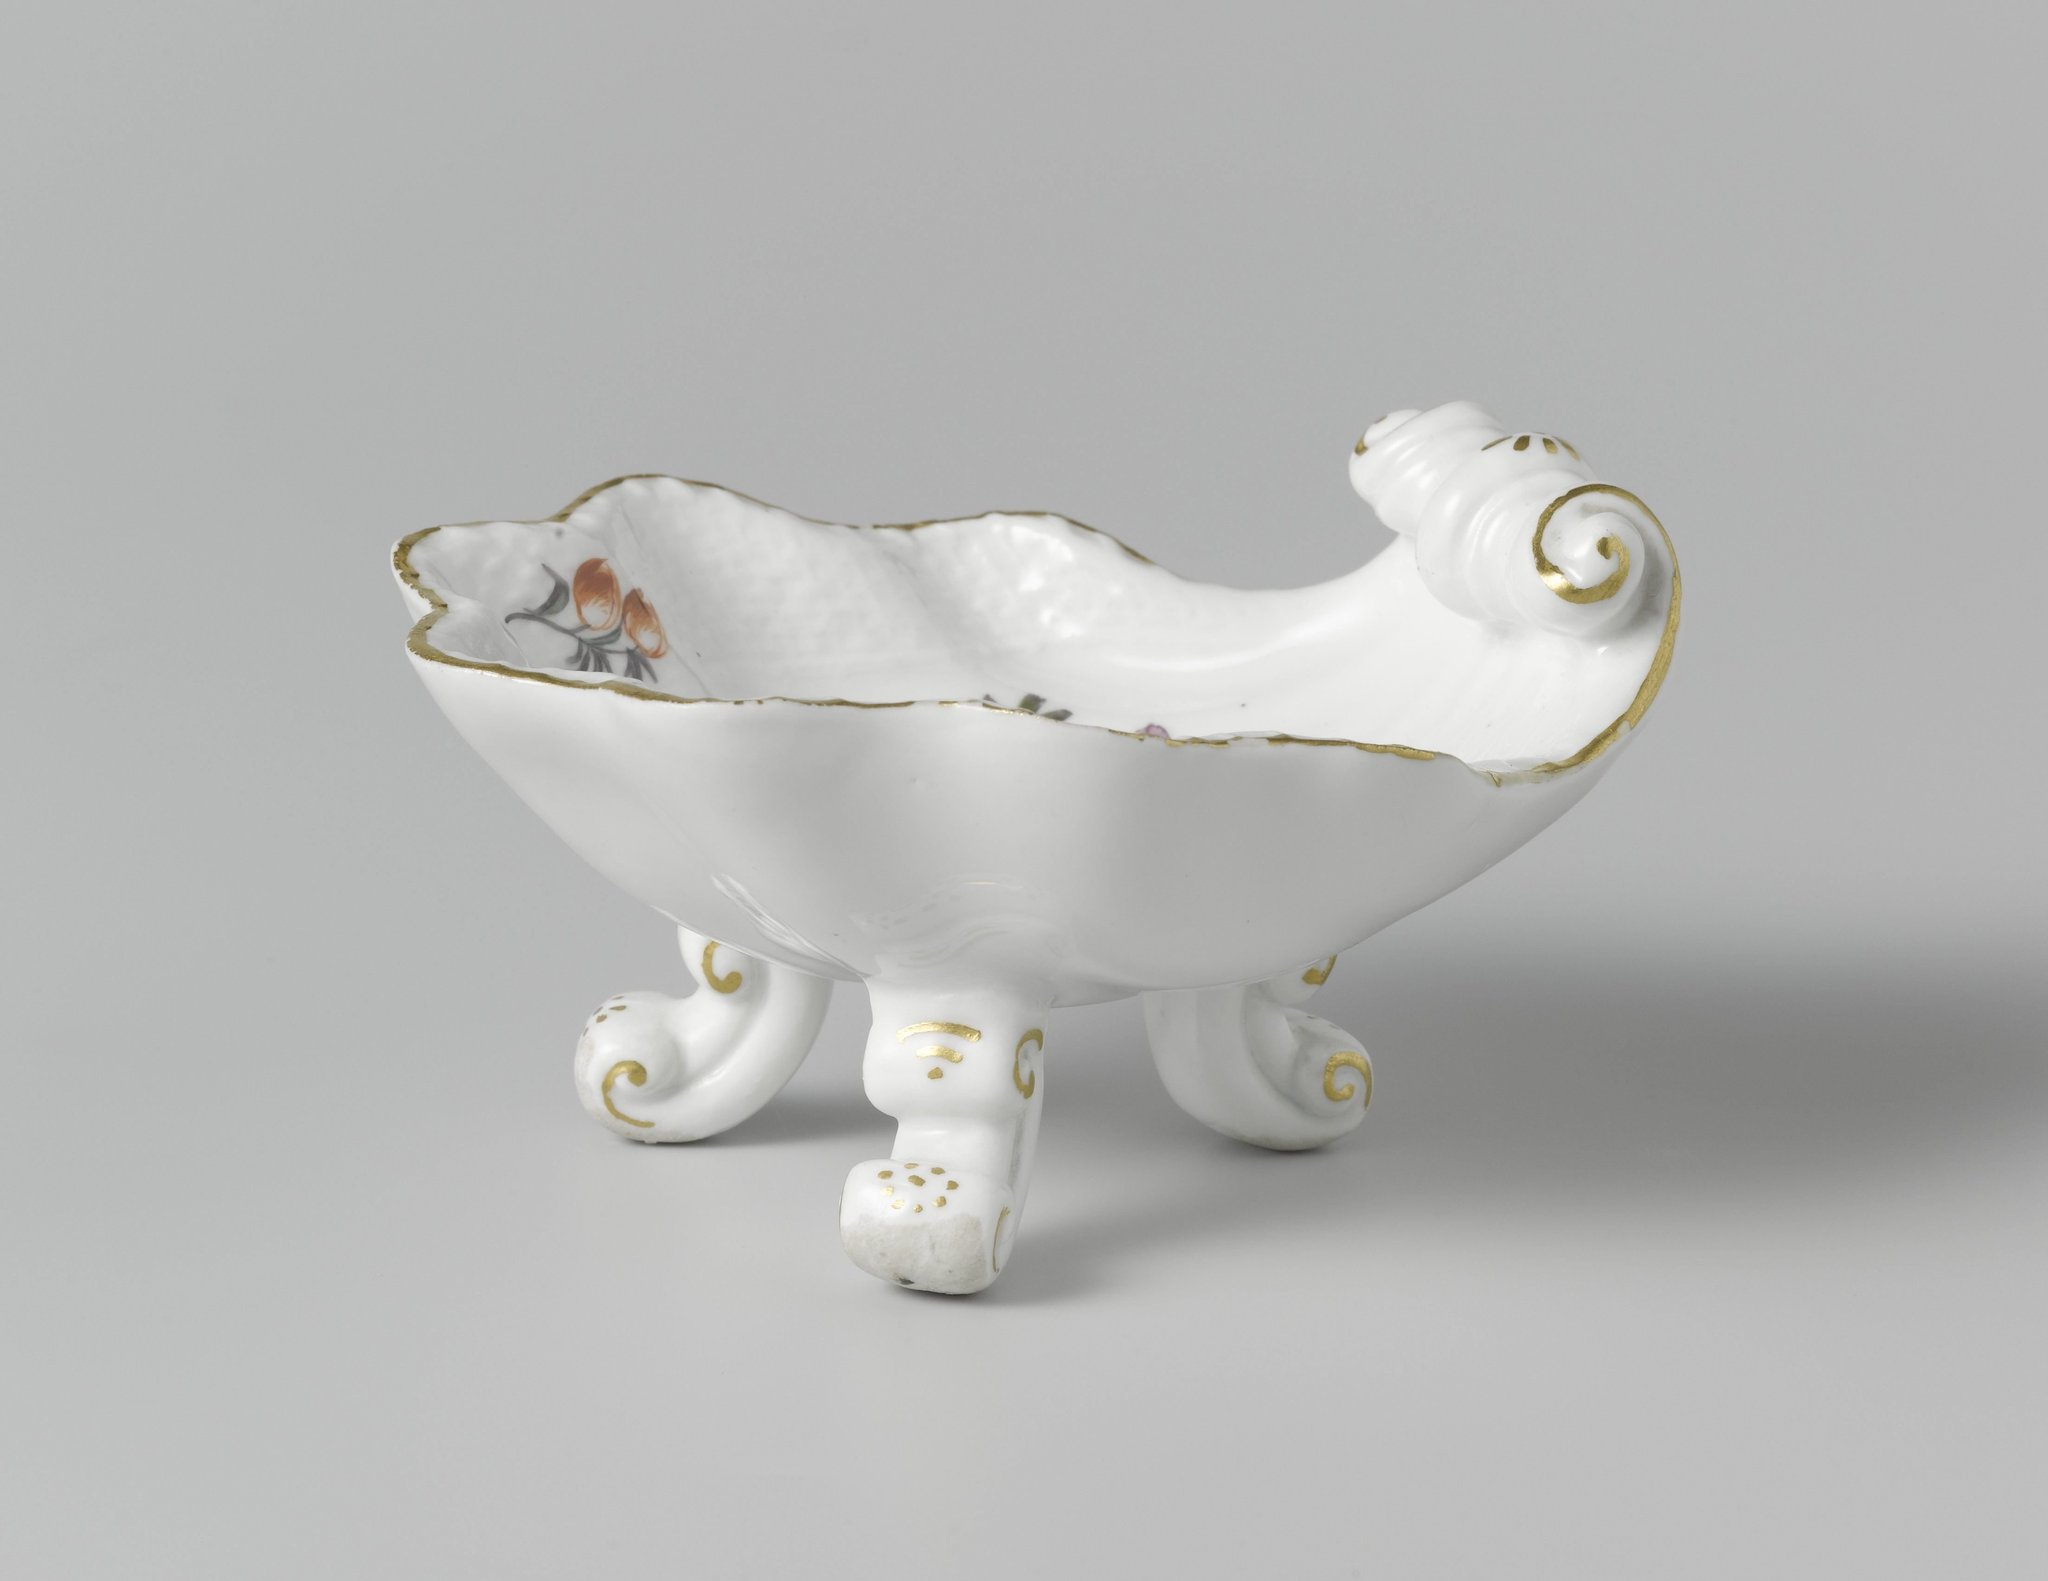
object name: salt condiment vessel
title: Zoutvat, veelkleurig beschilderd met Deutsche Blumen, insekten en vruchten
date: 1750-1760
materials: porcelain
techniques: painted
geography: meissen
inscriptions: factory mark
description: Zoutvat van beschilderd porselein. Het zoutvat heeft de vorm van een schelp met een geschulpte rand en staat op drie voluutvormige poten. Het zoutvat is beschilderd met Deutsche Blumen, insekten en vruchten. De rand is versierd met het Neuozier-patroon in reliëf. Het zoutvat is gemerkt en hoort bij een servies (BK-17474-1 t/m BK-17474-253).